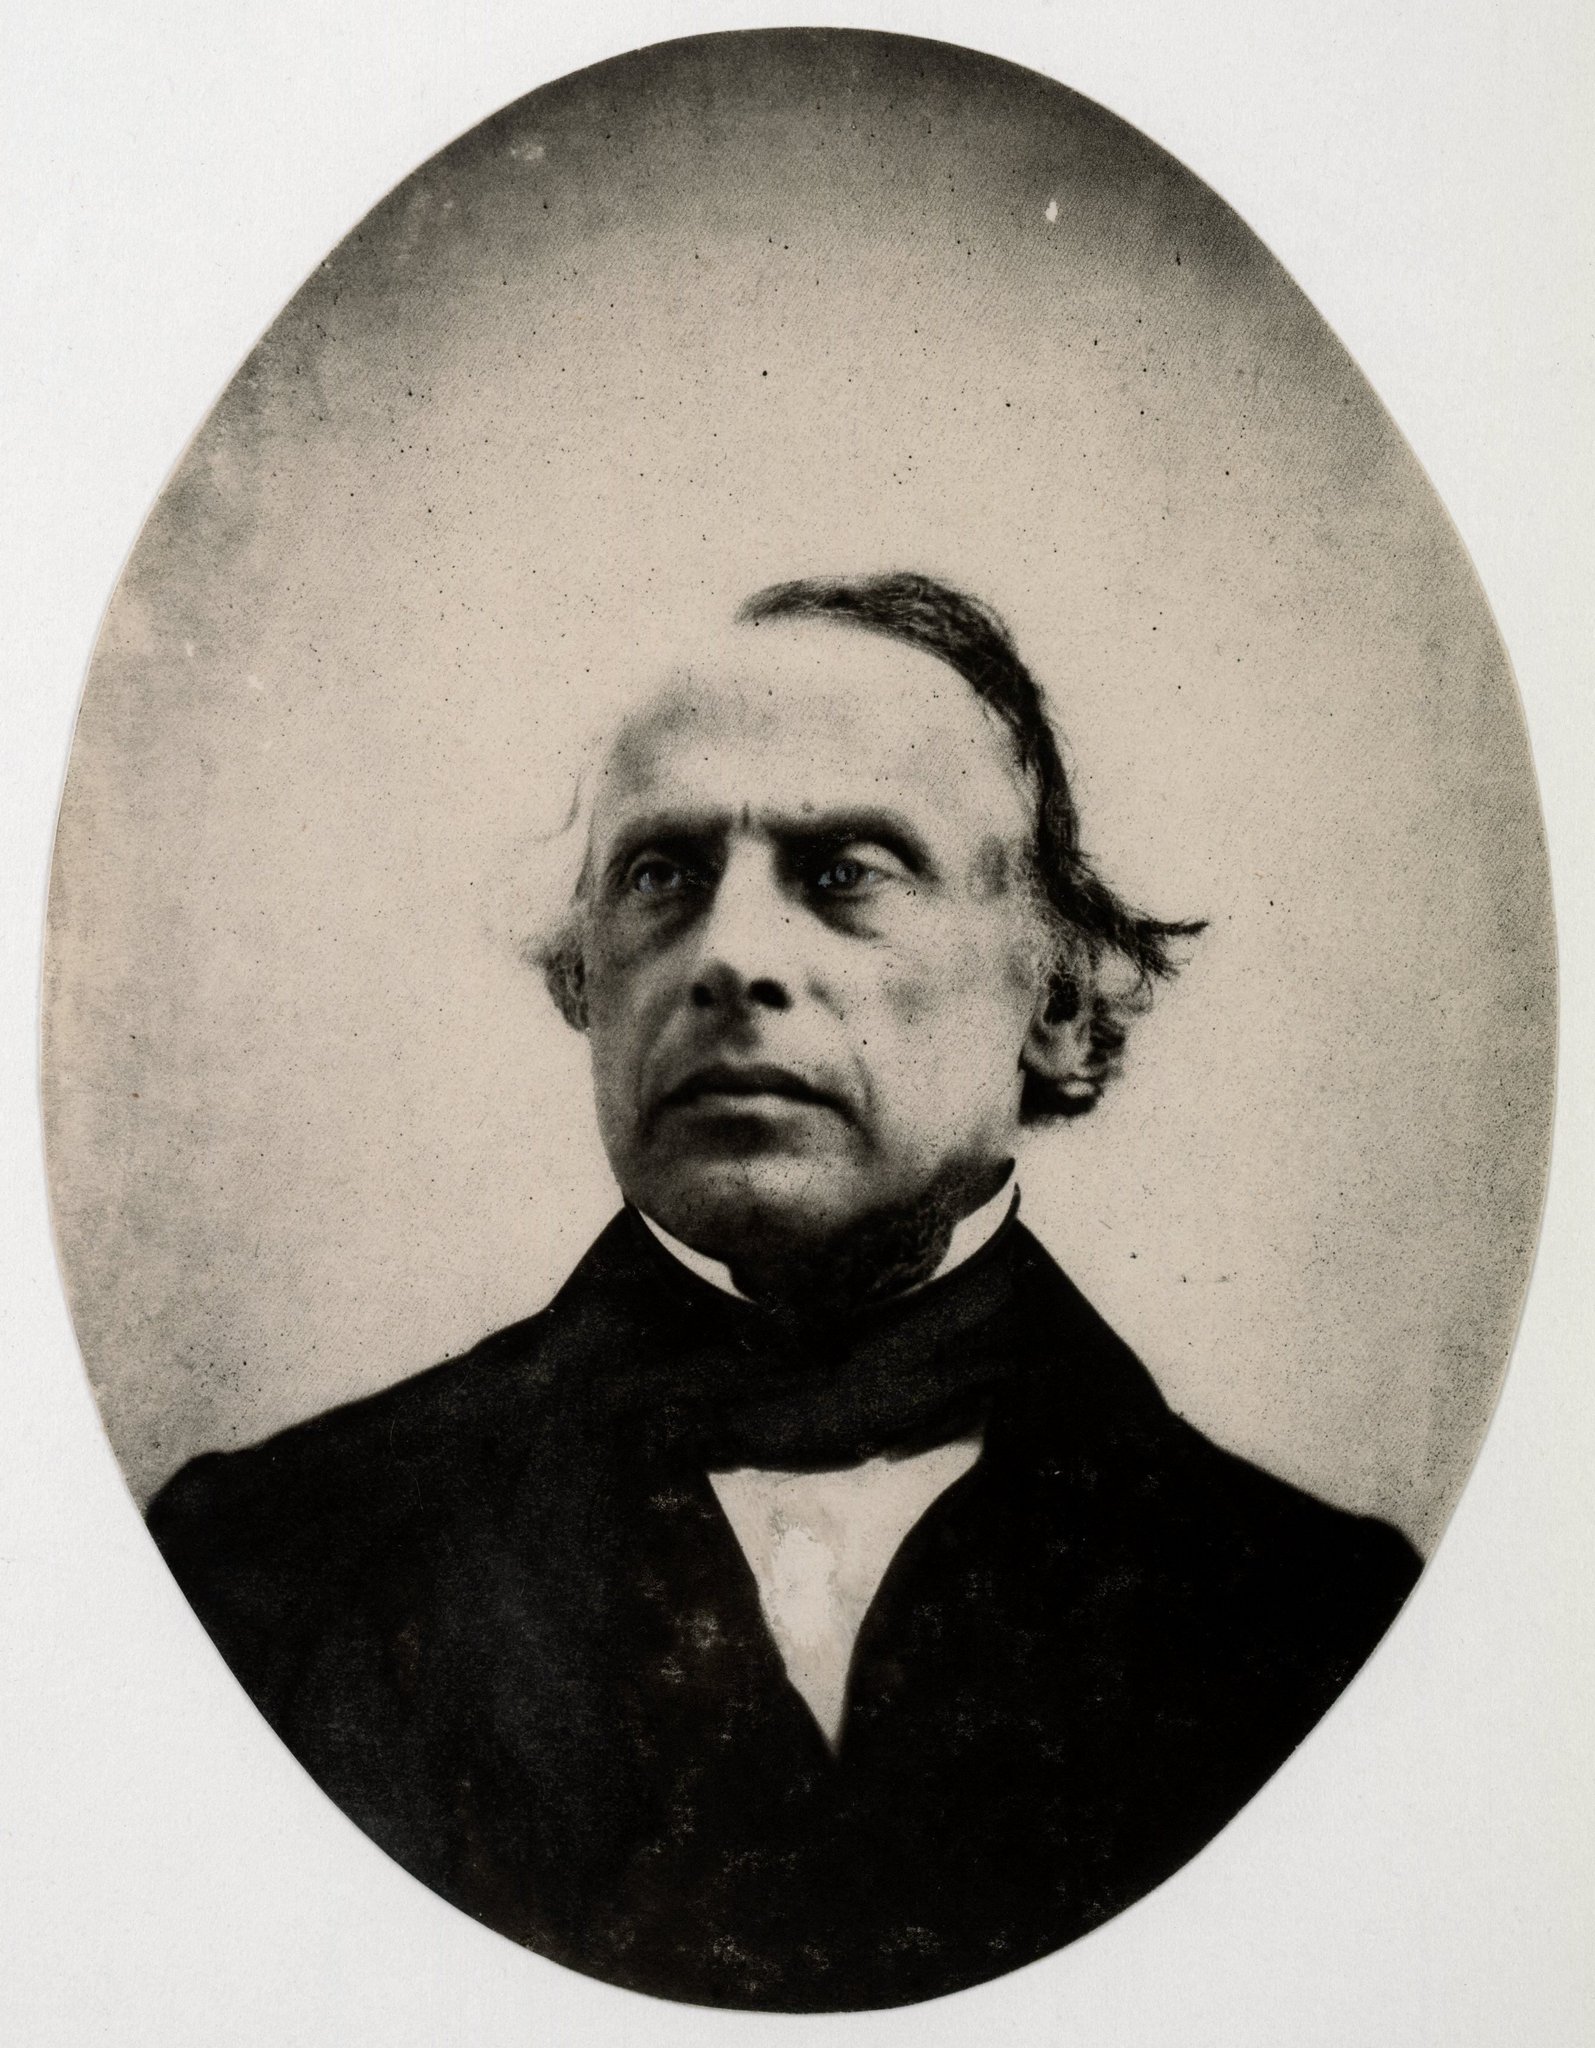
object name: photograph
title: Portret van Willem Nicolaas Rose 1801-1877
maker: Anonymous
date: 1840-1877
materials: paper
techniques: photolithography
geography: netherlands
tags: willem nicolaas rose, historical persons, portrait, self-portrait of architect, historical persons (portraits and scenes from the life) (+ (full) bust portrait)